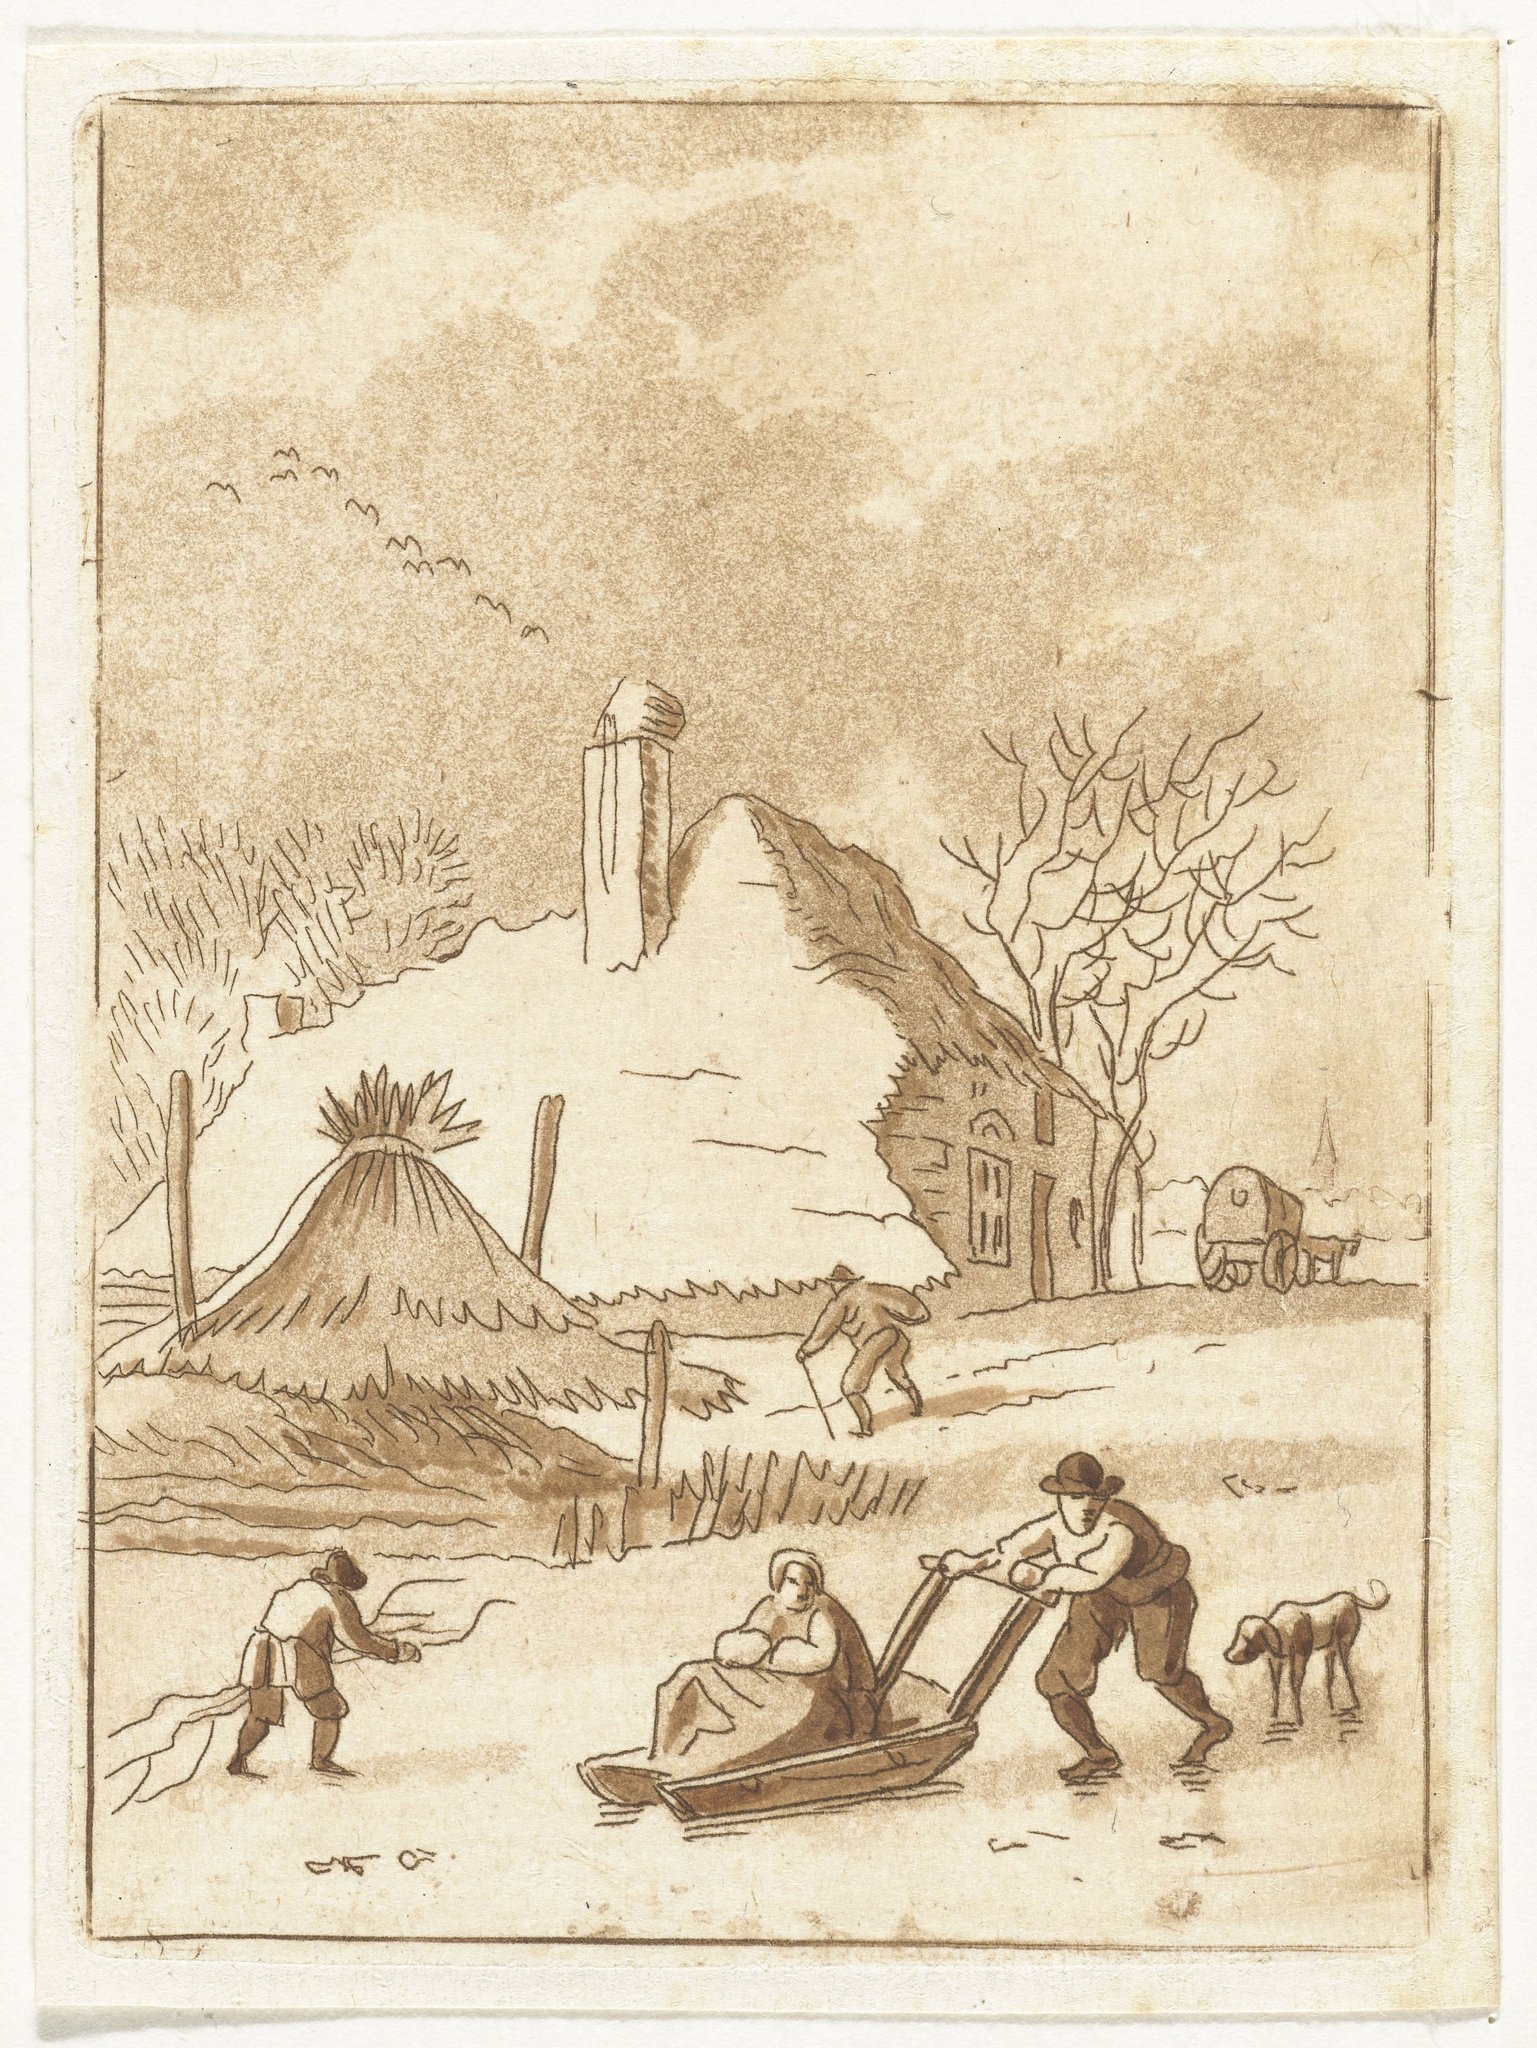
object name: print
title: Winterlandschap met ijsvermaak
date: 1778-1838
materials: paper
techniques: aquatint, etching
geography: netherlands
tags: winter sports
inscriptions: collector's mark: Lugt 2228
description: Winterlandschap. Op een bevroren rivier duwt een boer een slede met een vrouw. Achter hem aan loopt een hond. Links loopt een jongen die takken vergaart heeft. Op de achtergrond een huis met een kar ervoor.